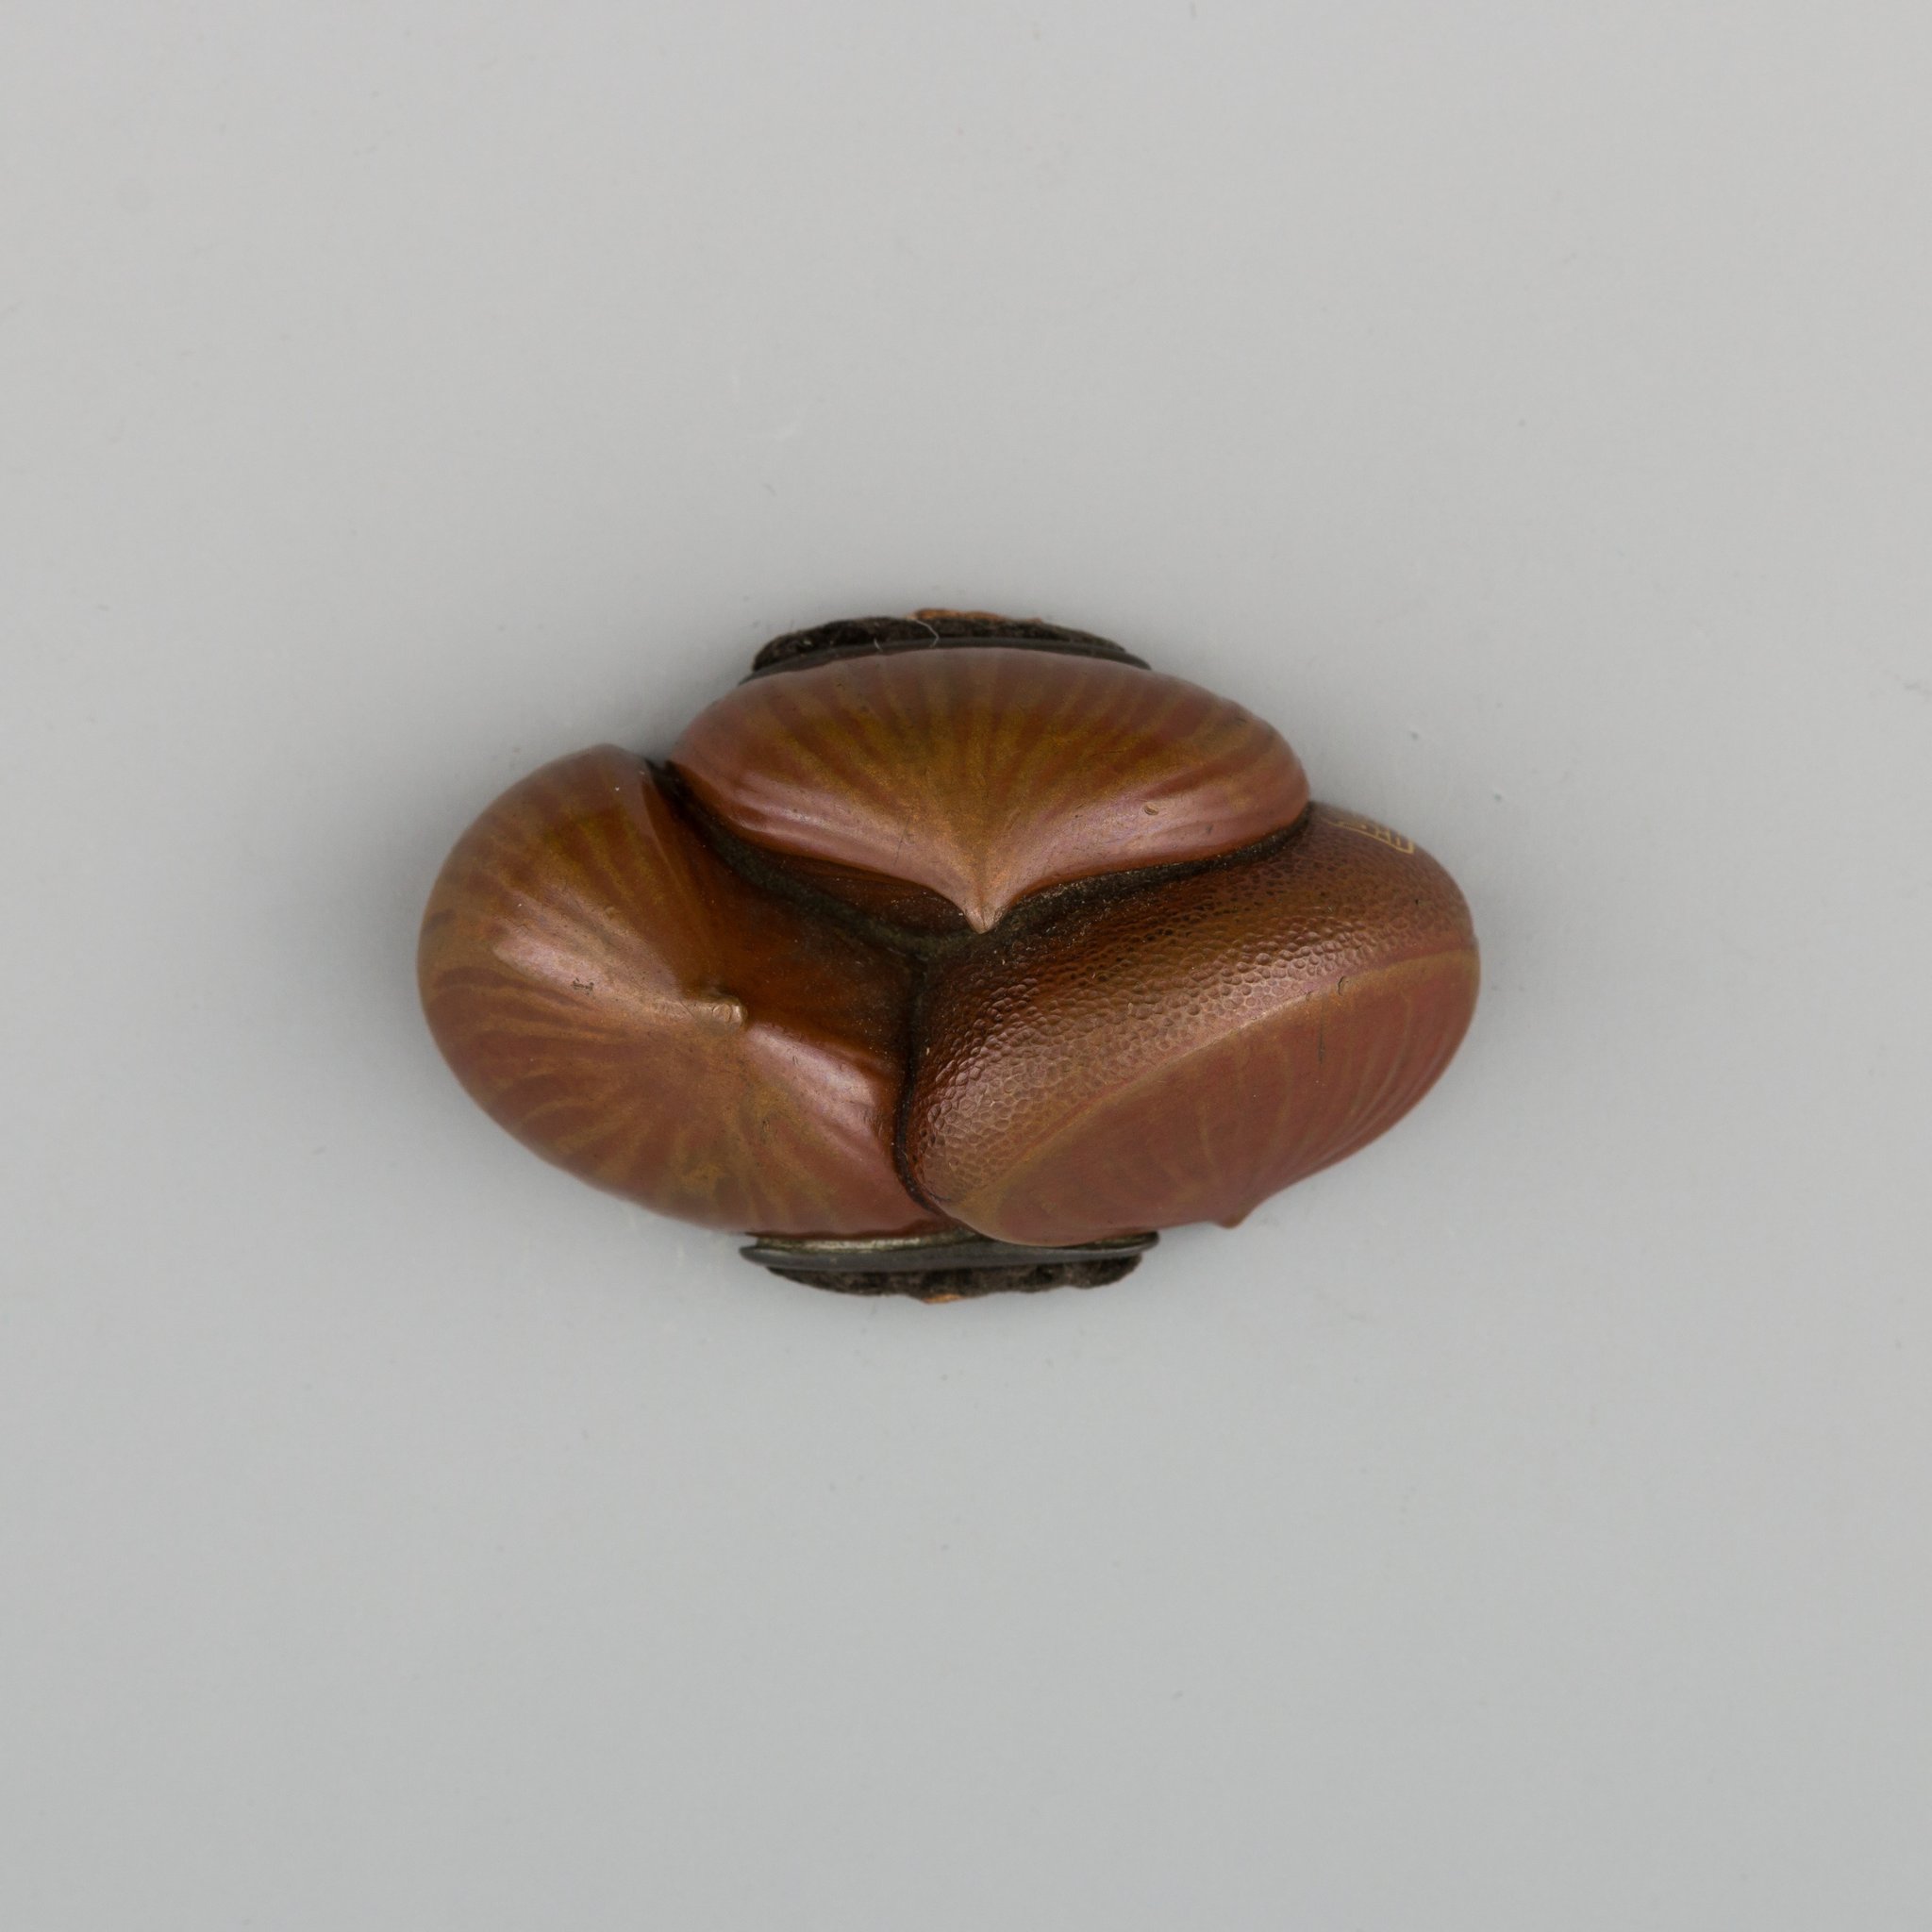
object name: sword pommel kashira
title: Sword Pommel (Kashira)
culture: japanese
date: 1615-1868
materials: copper, gold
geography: japan